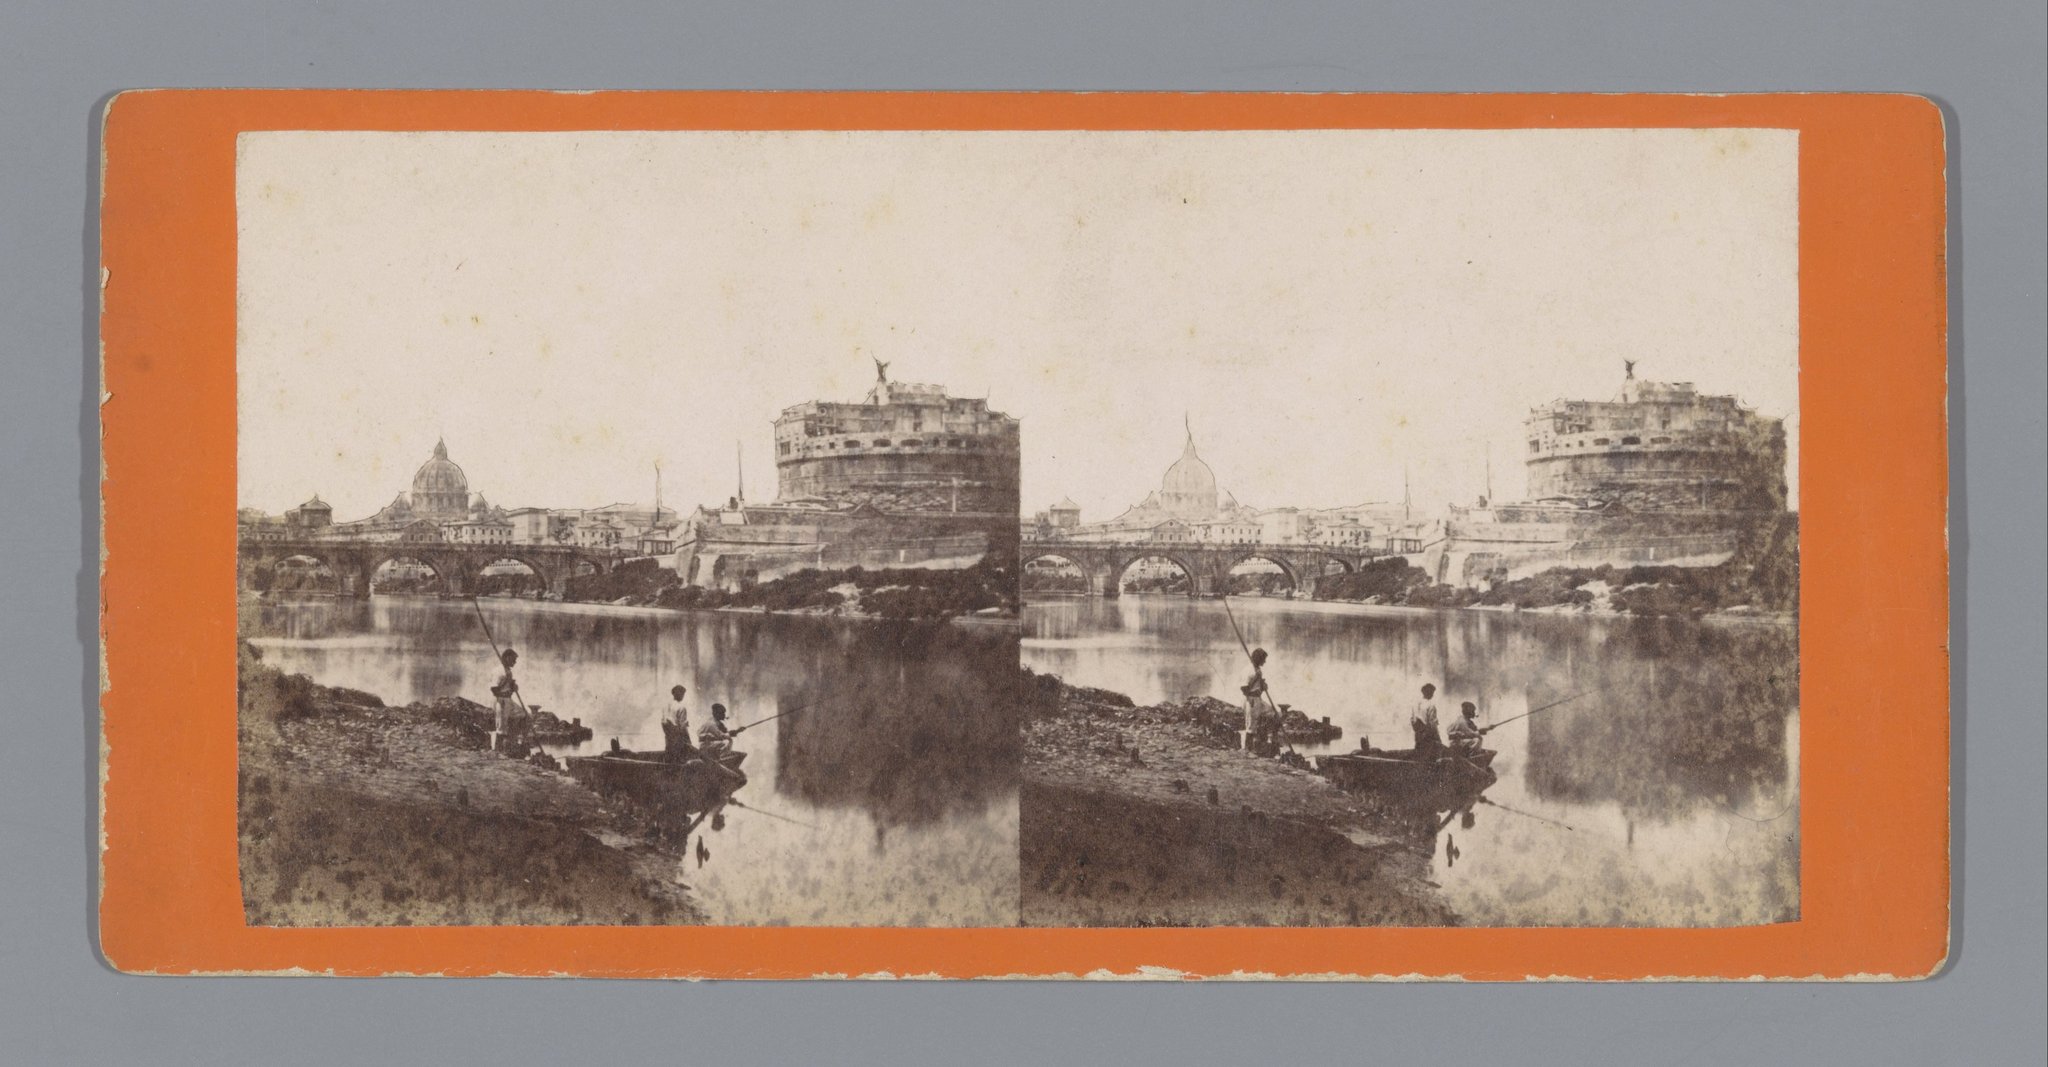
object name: stereograph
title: Gezicht op de Engelenbrug en de Engelenburcht te Rome, met op de voorgrond vissende mannen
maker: Anonymous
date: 1850-1880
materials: cardboard, photographic support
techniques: albumen print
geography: rome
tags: landscape with bridge, viaduct or aqueduct, fisherman, rome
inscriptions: inscription: ‘Roma Ponte e Castel Sant'Angelo’